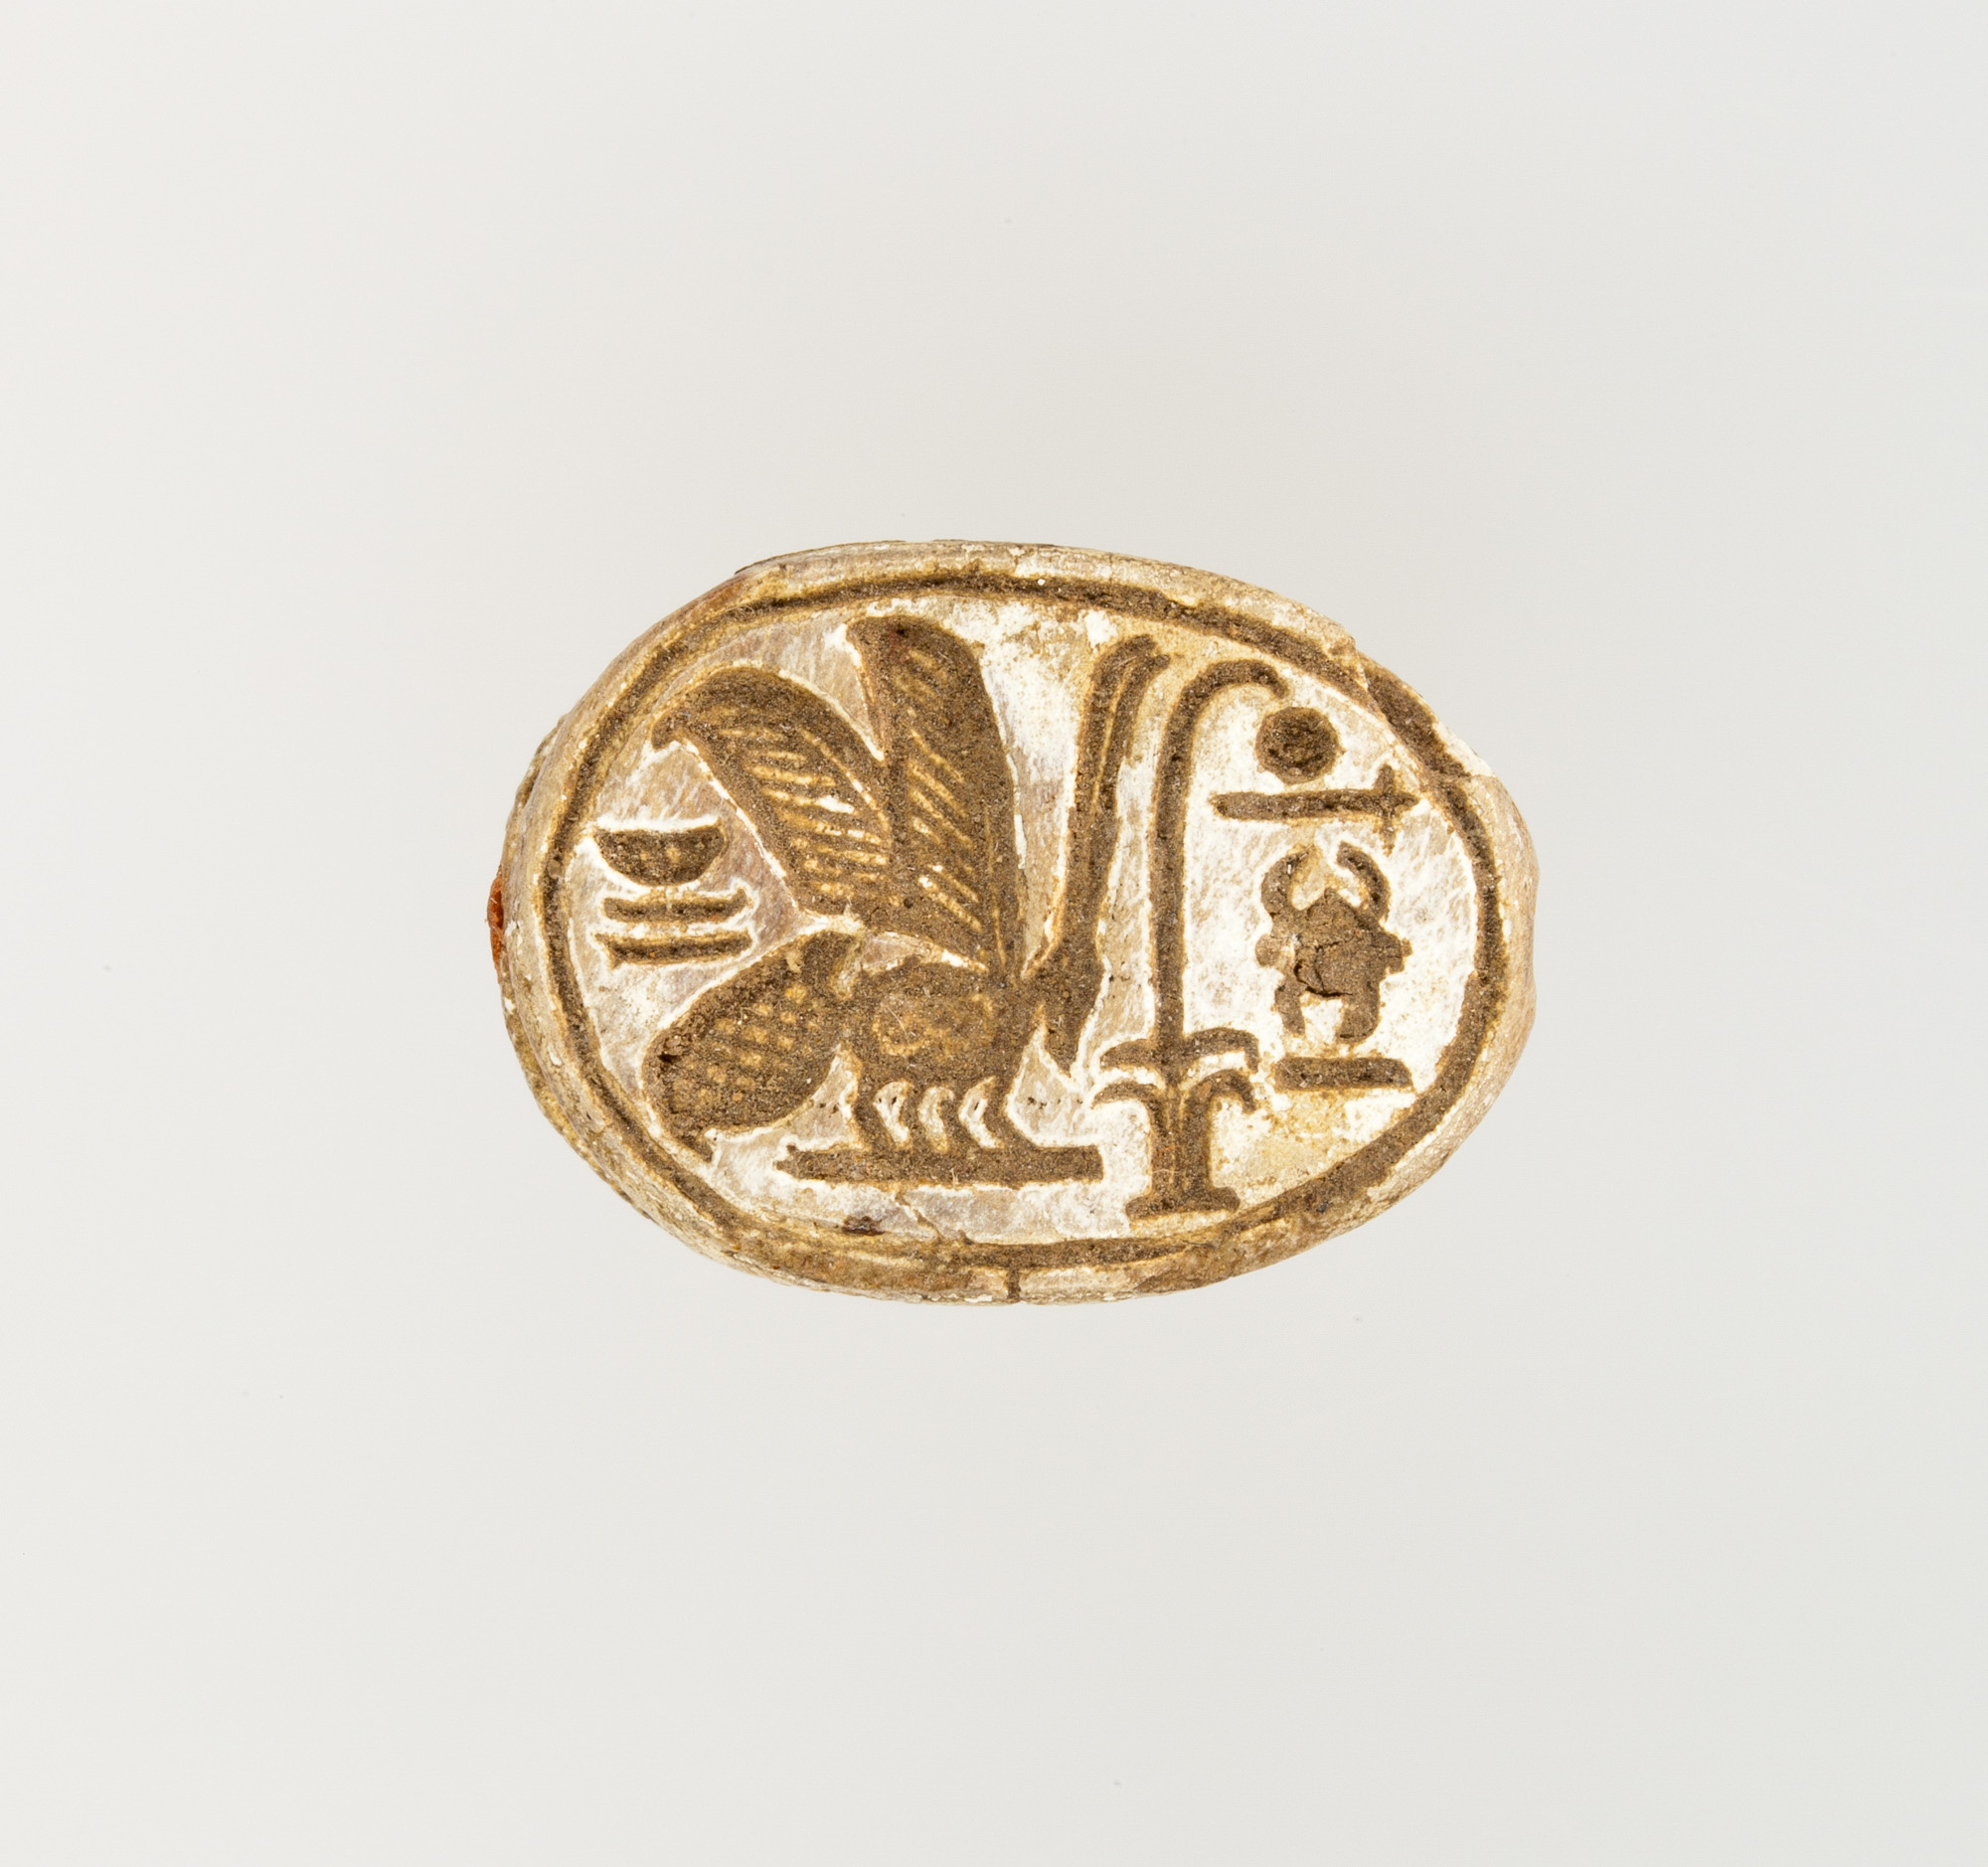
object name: scarab, thutmose ii, aakheperenre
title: Scarab Inscribed with the Throne Name of Thutmose II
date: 1492-1479 BCE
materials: stone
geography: egypt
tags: hieroglyphs,scarabs